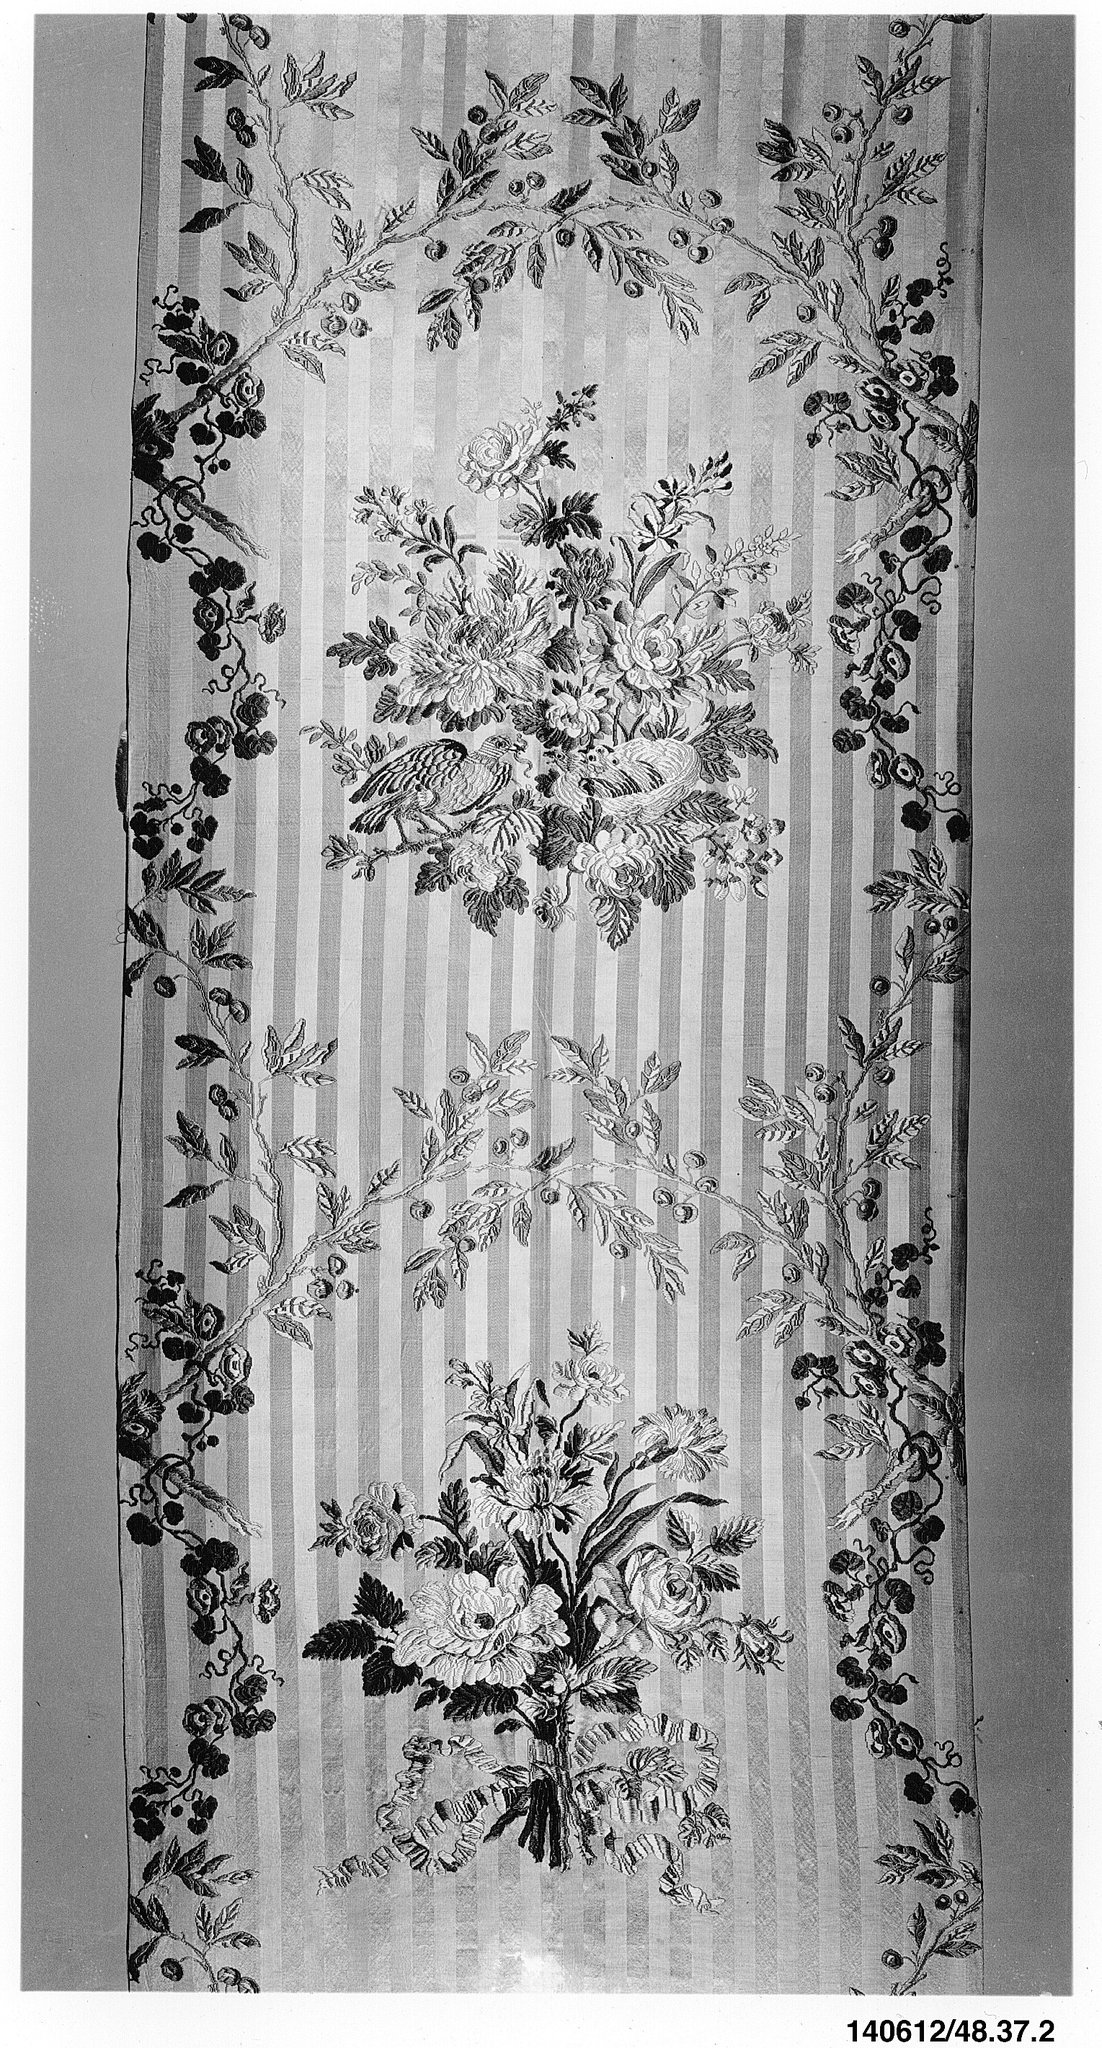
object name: piece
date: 1770-1780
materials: silk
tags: flowers,leaves